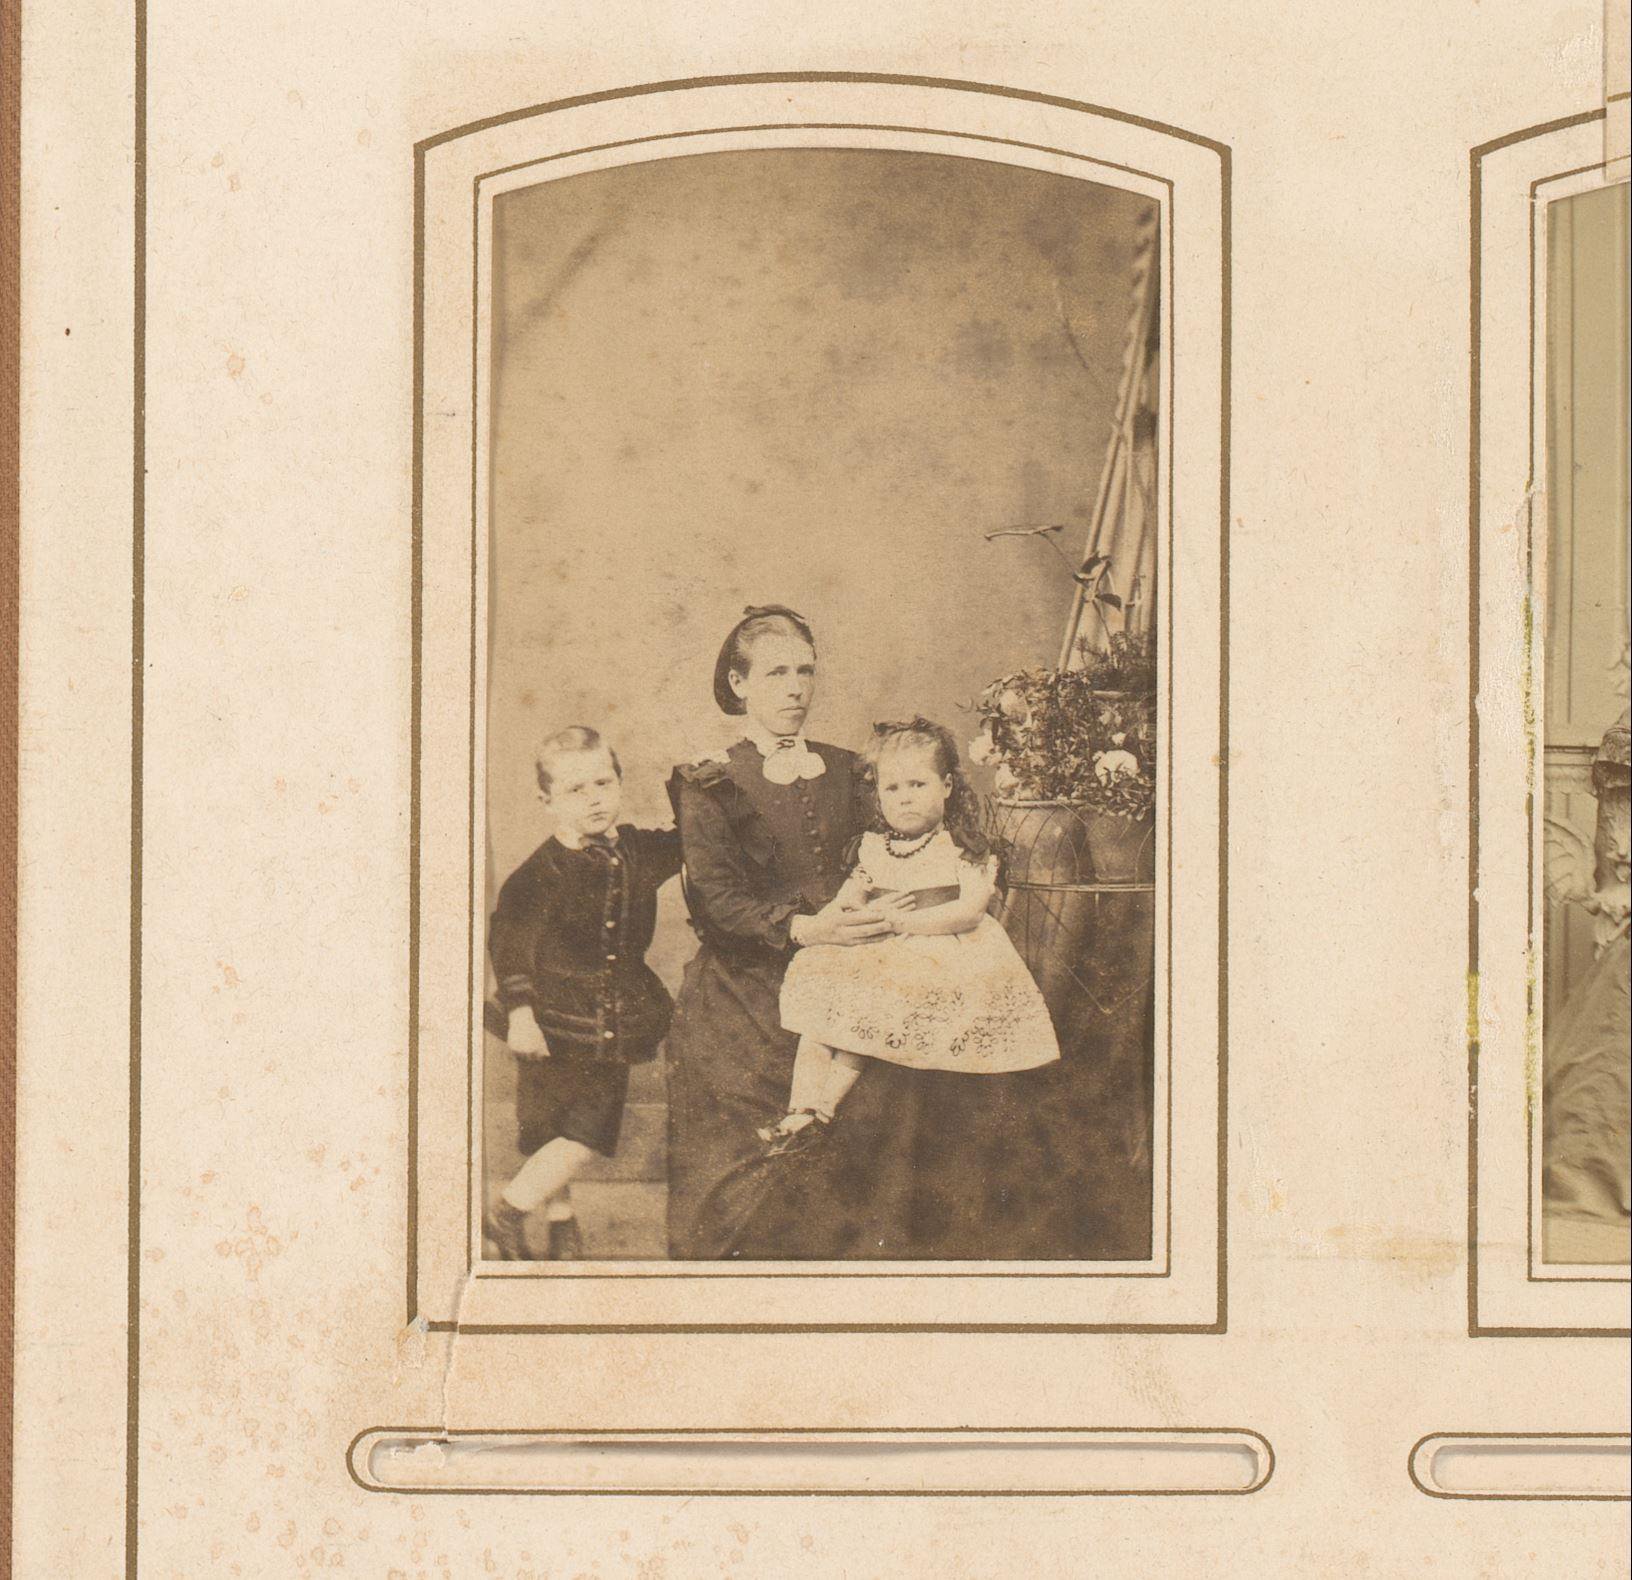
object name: photograph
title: Portret van een zittende vrouw, aangeduid als Bertha, en twee kinderen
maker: f. foster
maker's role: fotograaf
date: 1860-1875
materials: cardboard, paper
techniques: albumen print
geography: odiham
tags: sitting figure, historical persons - bb - woman, mother and child(ren), woman and child(ren) (family group)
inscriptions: inscription: ‘F. FOSTER, Photographer,/ ODIHAM,/ HANTS./ MEMORIAM REI REPRAESENTARE./ No./ Negative kept Copies may be had/ at any time’, inscription: ‘Bertha/ with love/ [...]’